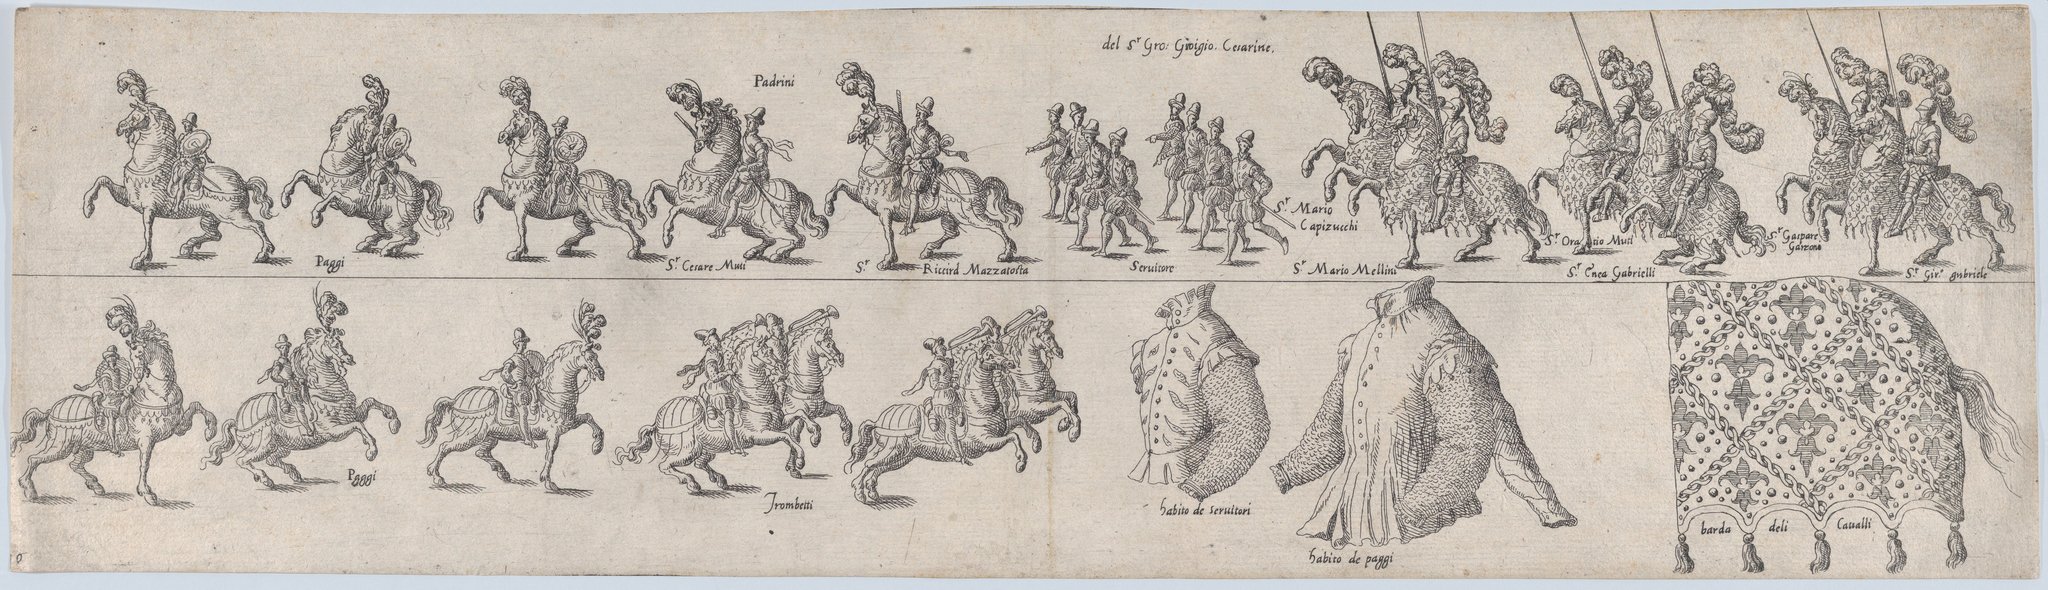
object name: print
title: Plate for Giorgio Cesarini, from a series of twelve showing knights and their attendants dressed for a tournament (plate 10)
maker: Anonymous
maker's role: artist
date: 1565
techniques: etching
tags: armor,horses,knights